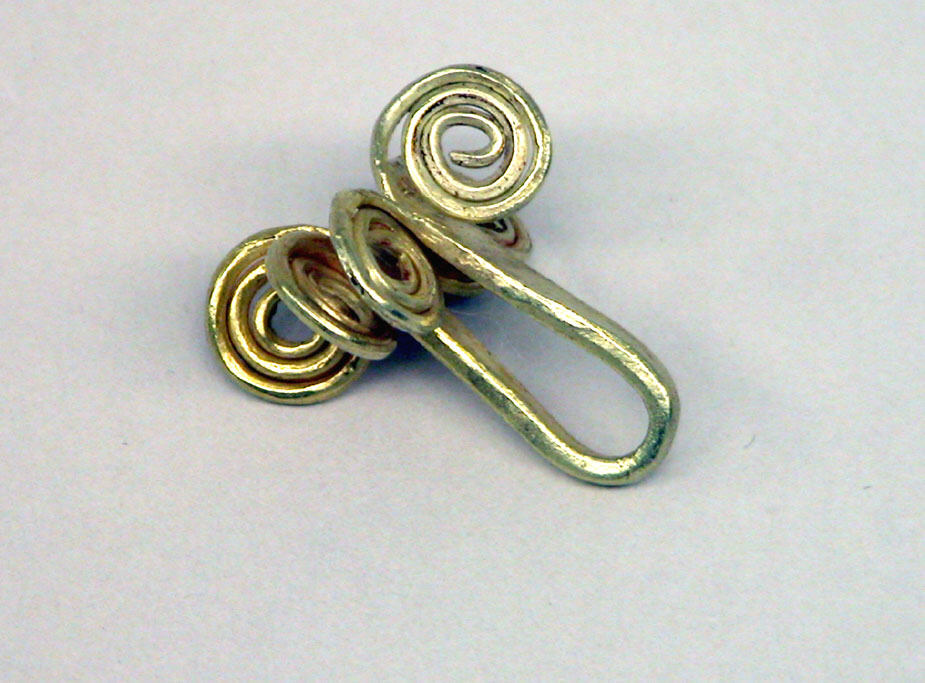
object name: pendant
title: Pendant Composed of Three Sets of Overlapping Volutes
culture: indonesian, javanese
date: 201-300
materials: gold